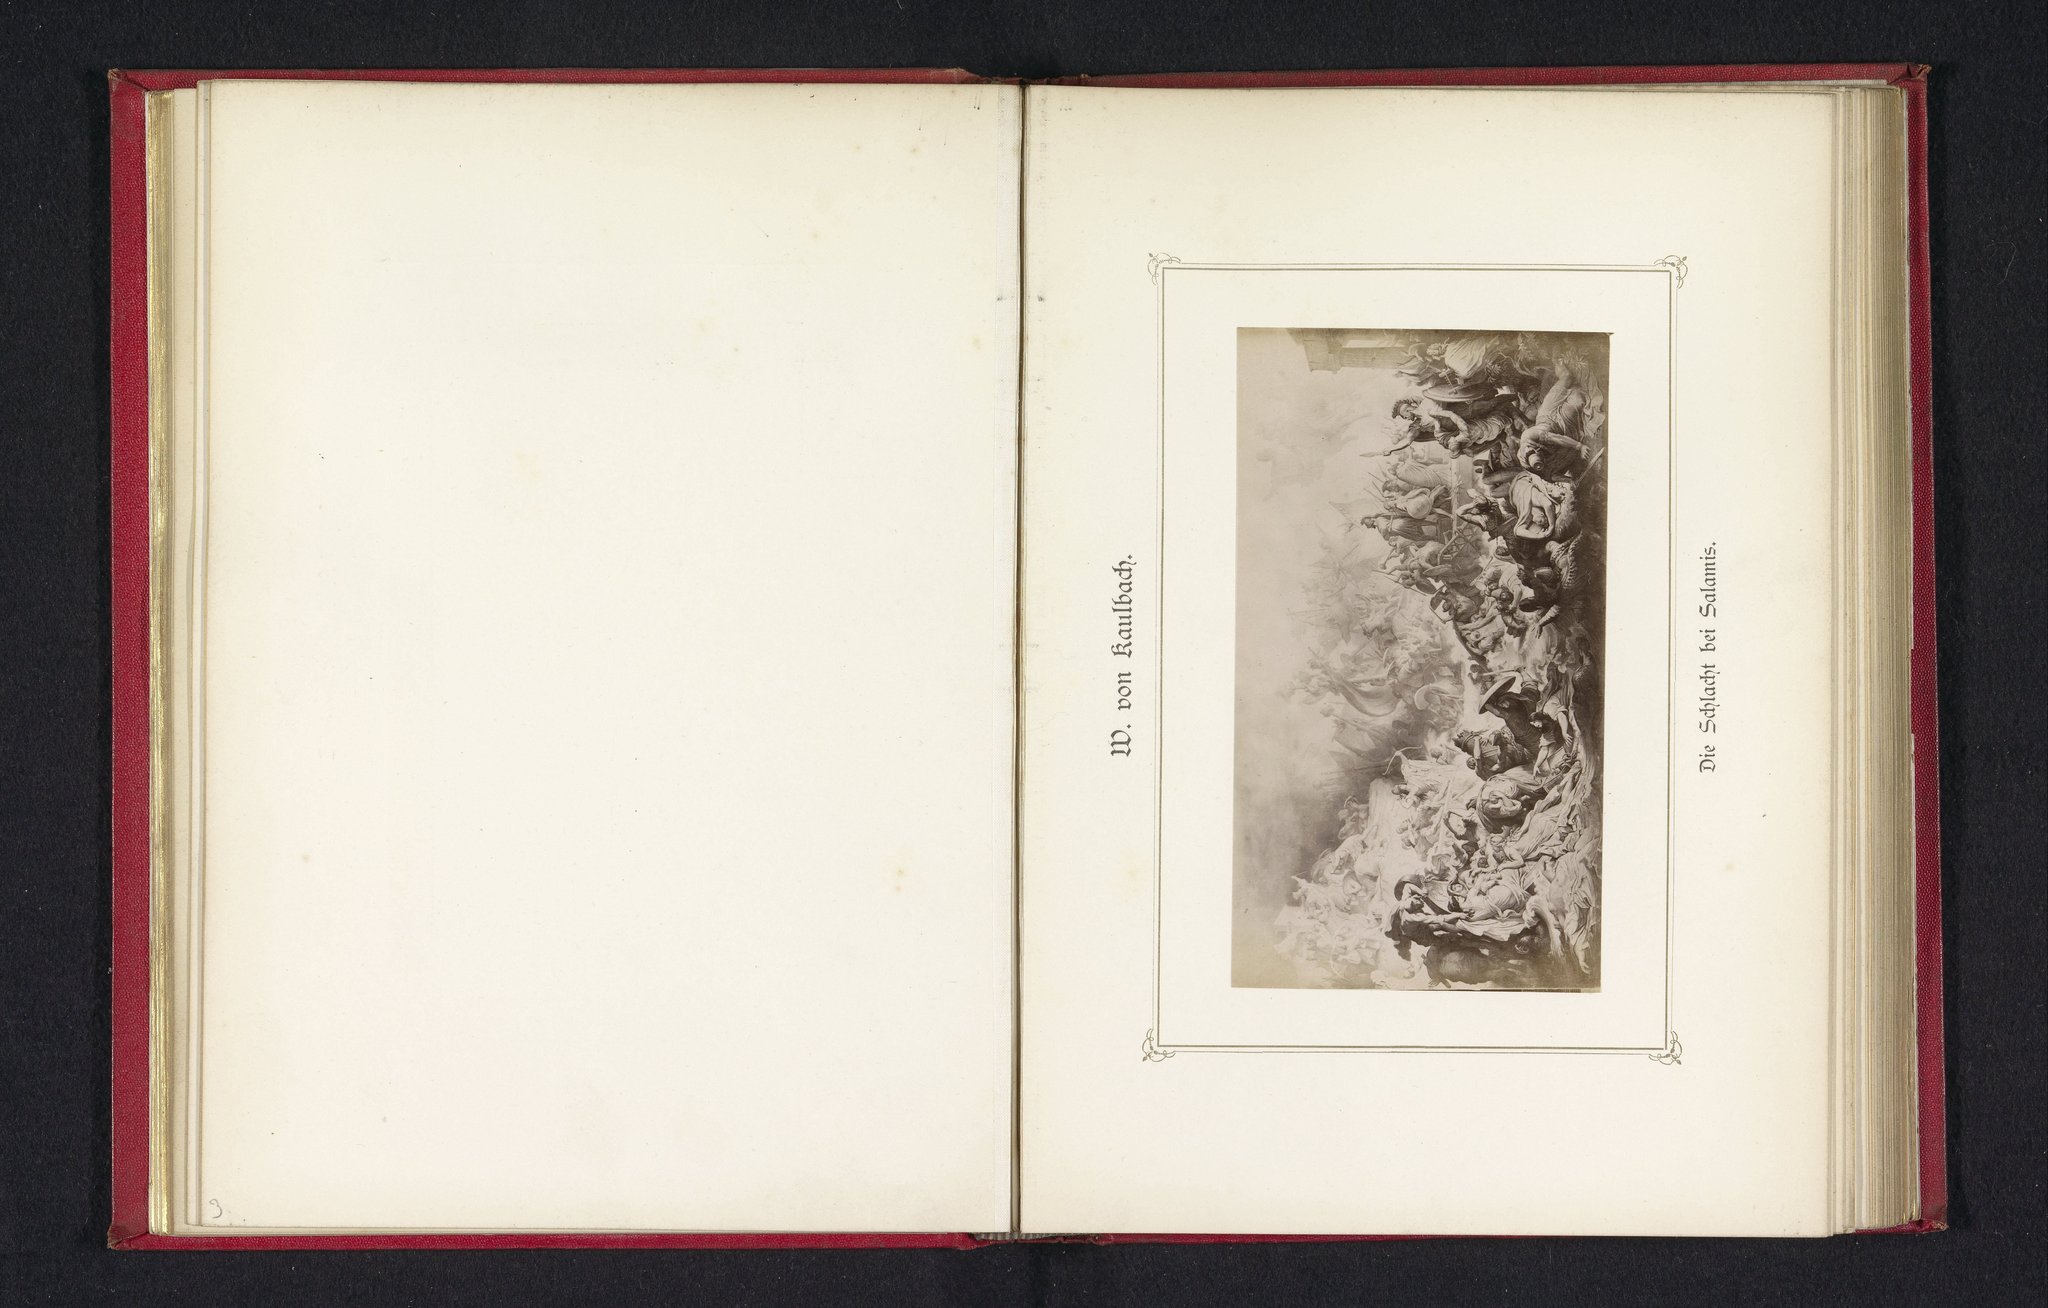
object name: reproduction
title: Die Schlacht bei Salamis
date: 1875-1880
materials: photographic support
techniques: albumen print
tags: battle